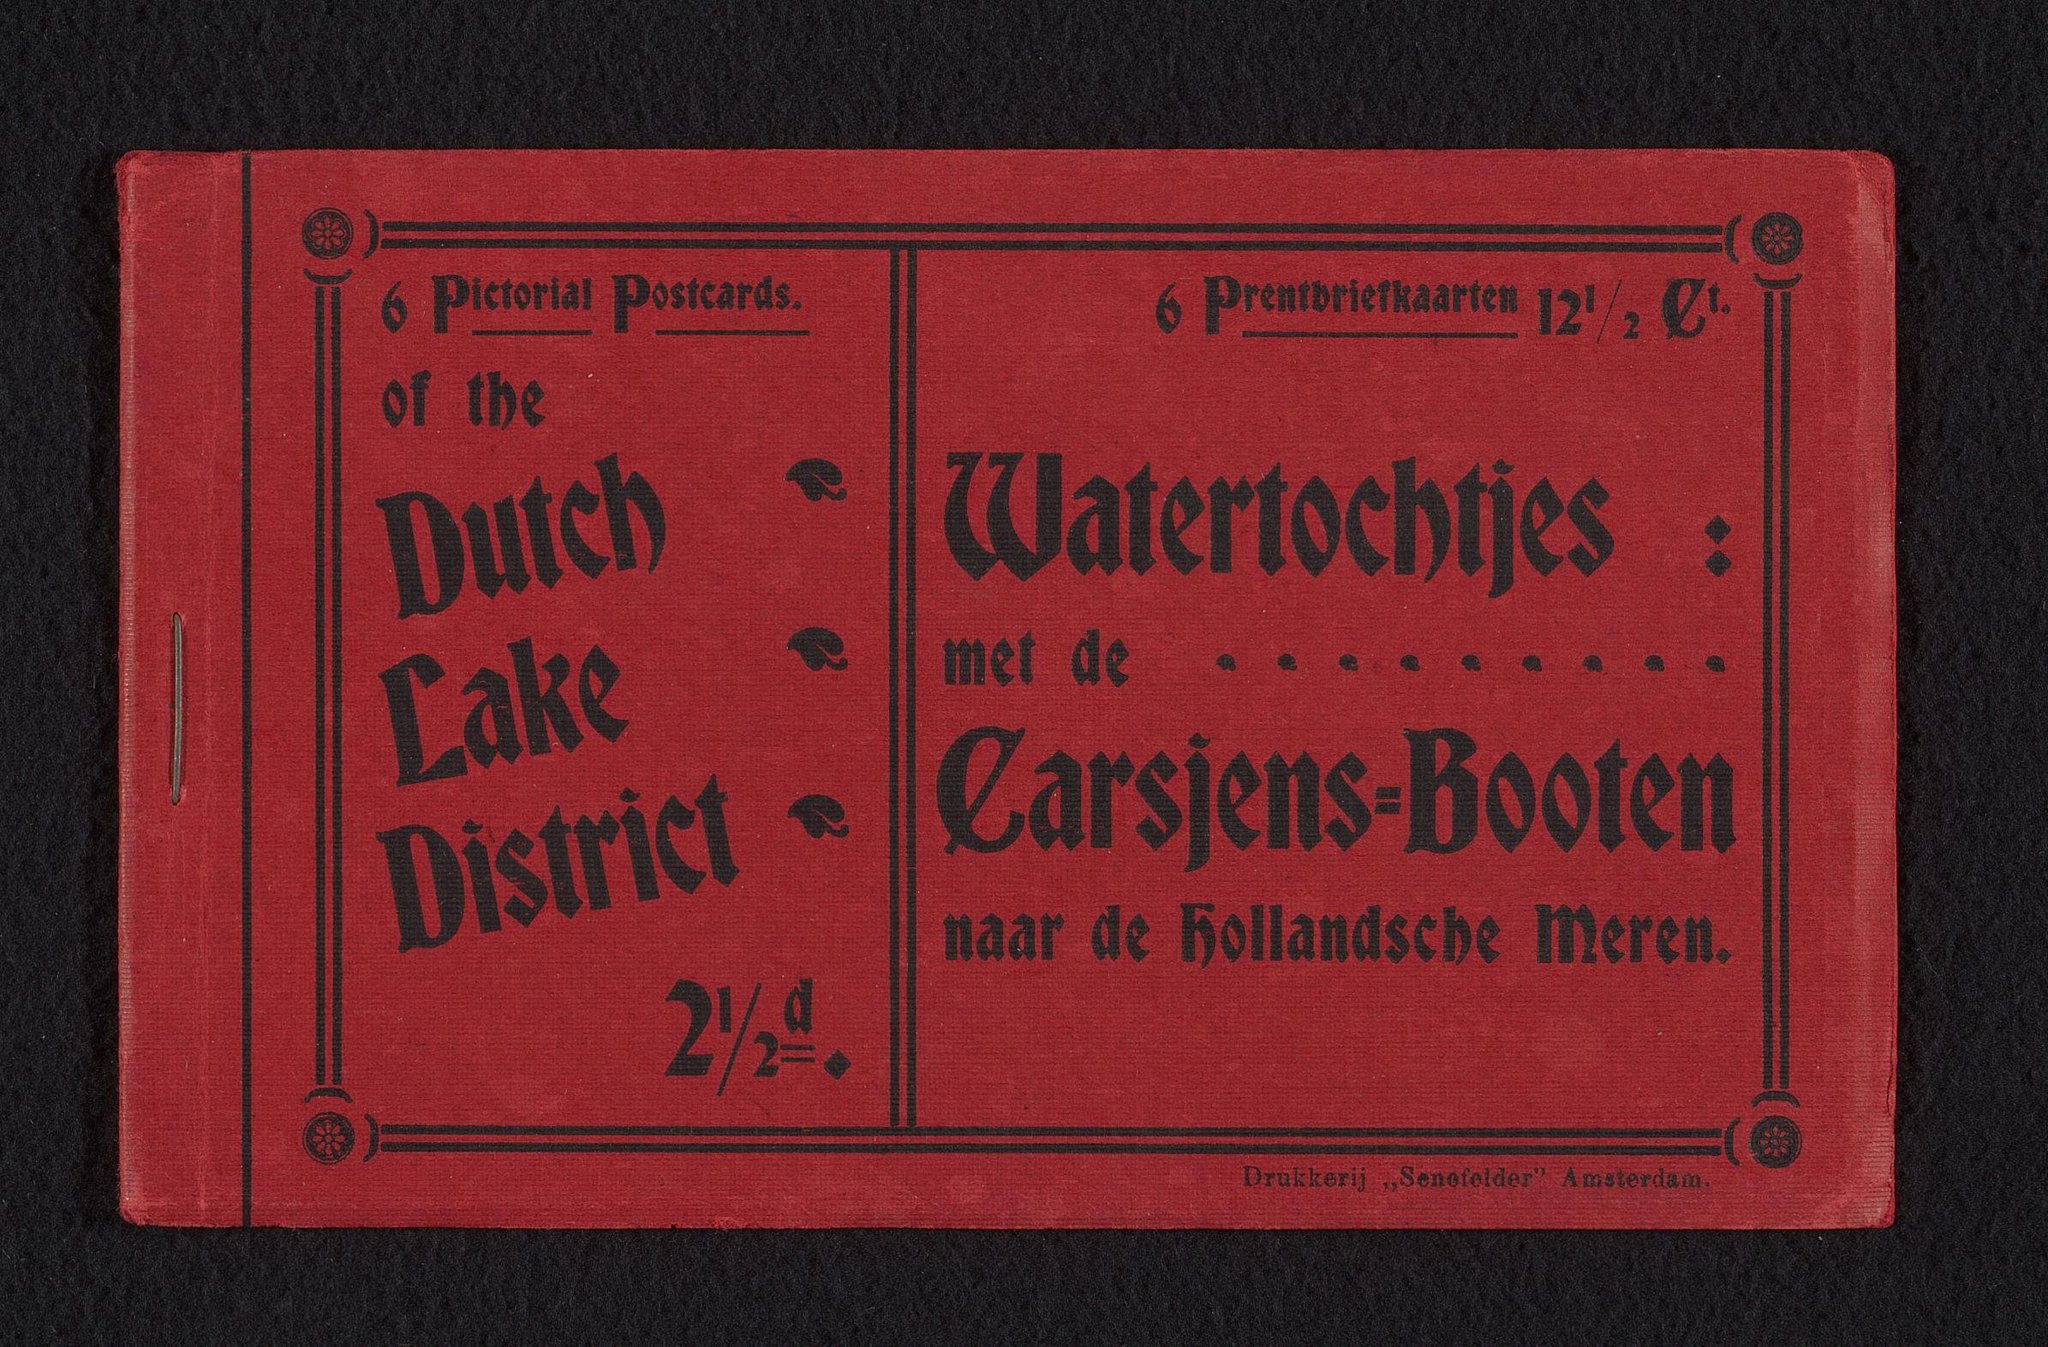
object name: album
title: 6 Prentbriefkaarten. Watertochtjes met de Carsjens-Booten naar de Hollandsche Meren / 6 Pictorial Postcards of the Dutch Lake District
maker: Anonymous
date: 1906-1915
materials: cardboard, paper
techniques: photograph, letterpress printing, stapling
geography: amsterdam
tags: recreation, lake, traffic on the water, netherlands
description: Album met zes prentbriefkaarten met voorstellingen op of bij Nederlandse meren. De kaarten dienen als reclame voor Carsjens, een stoombootmaatschappij waarmee men boottochtjes maakte. Op het achterblad staat een routekaart. De prentbriefkaarten kunnen eruit gescheurd worden.